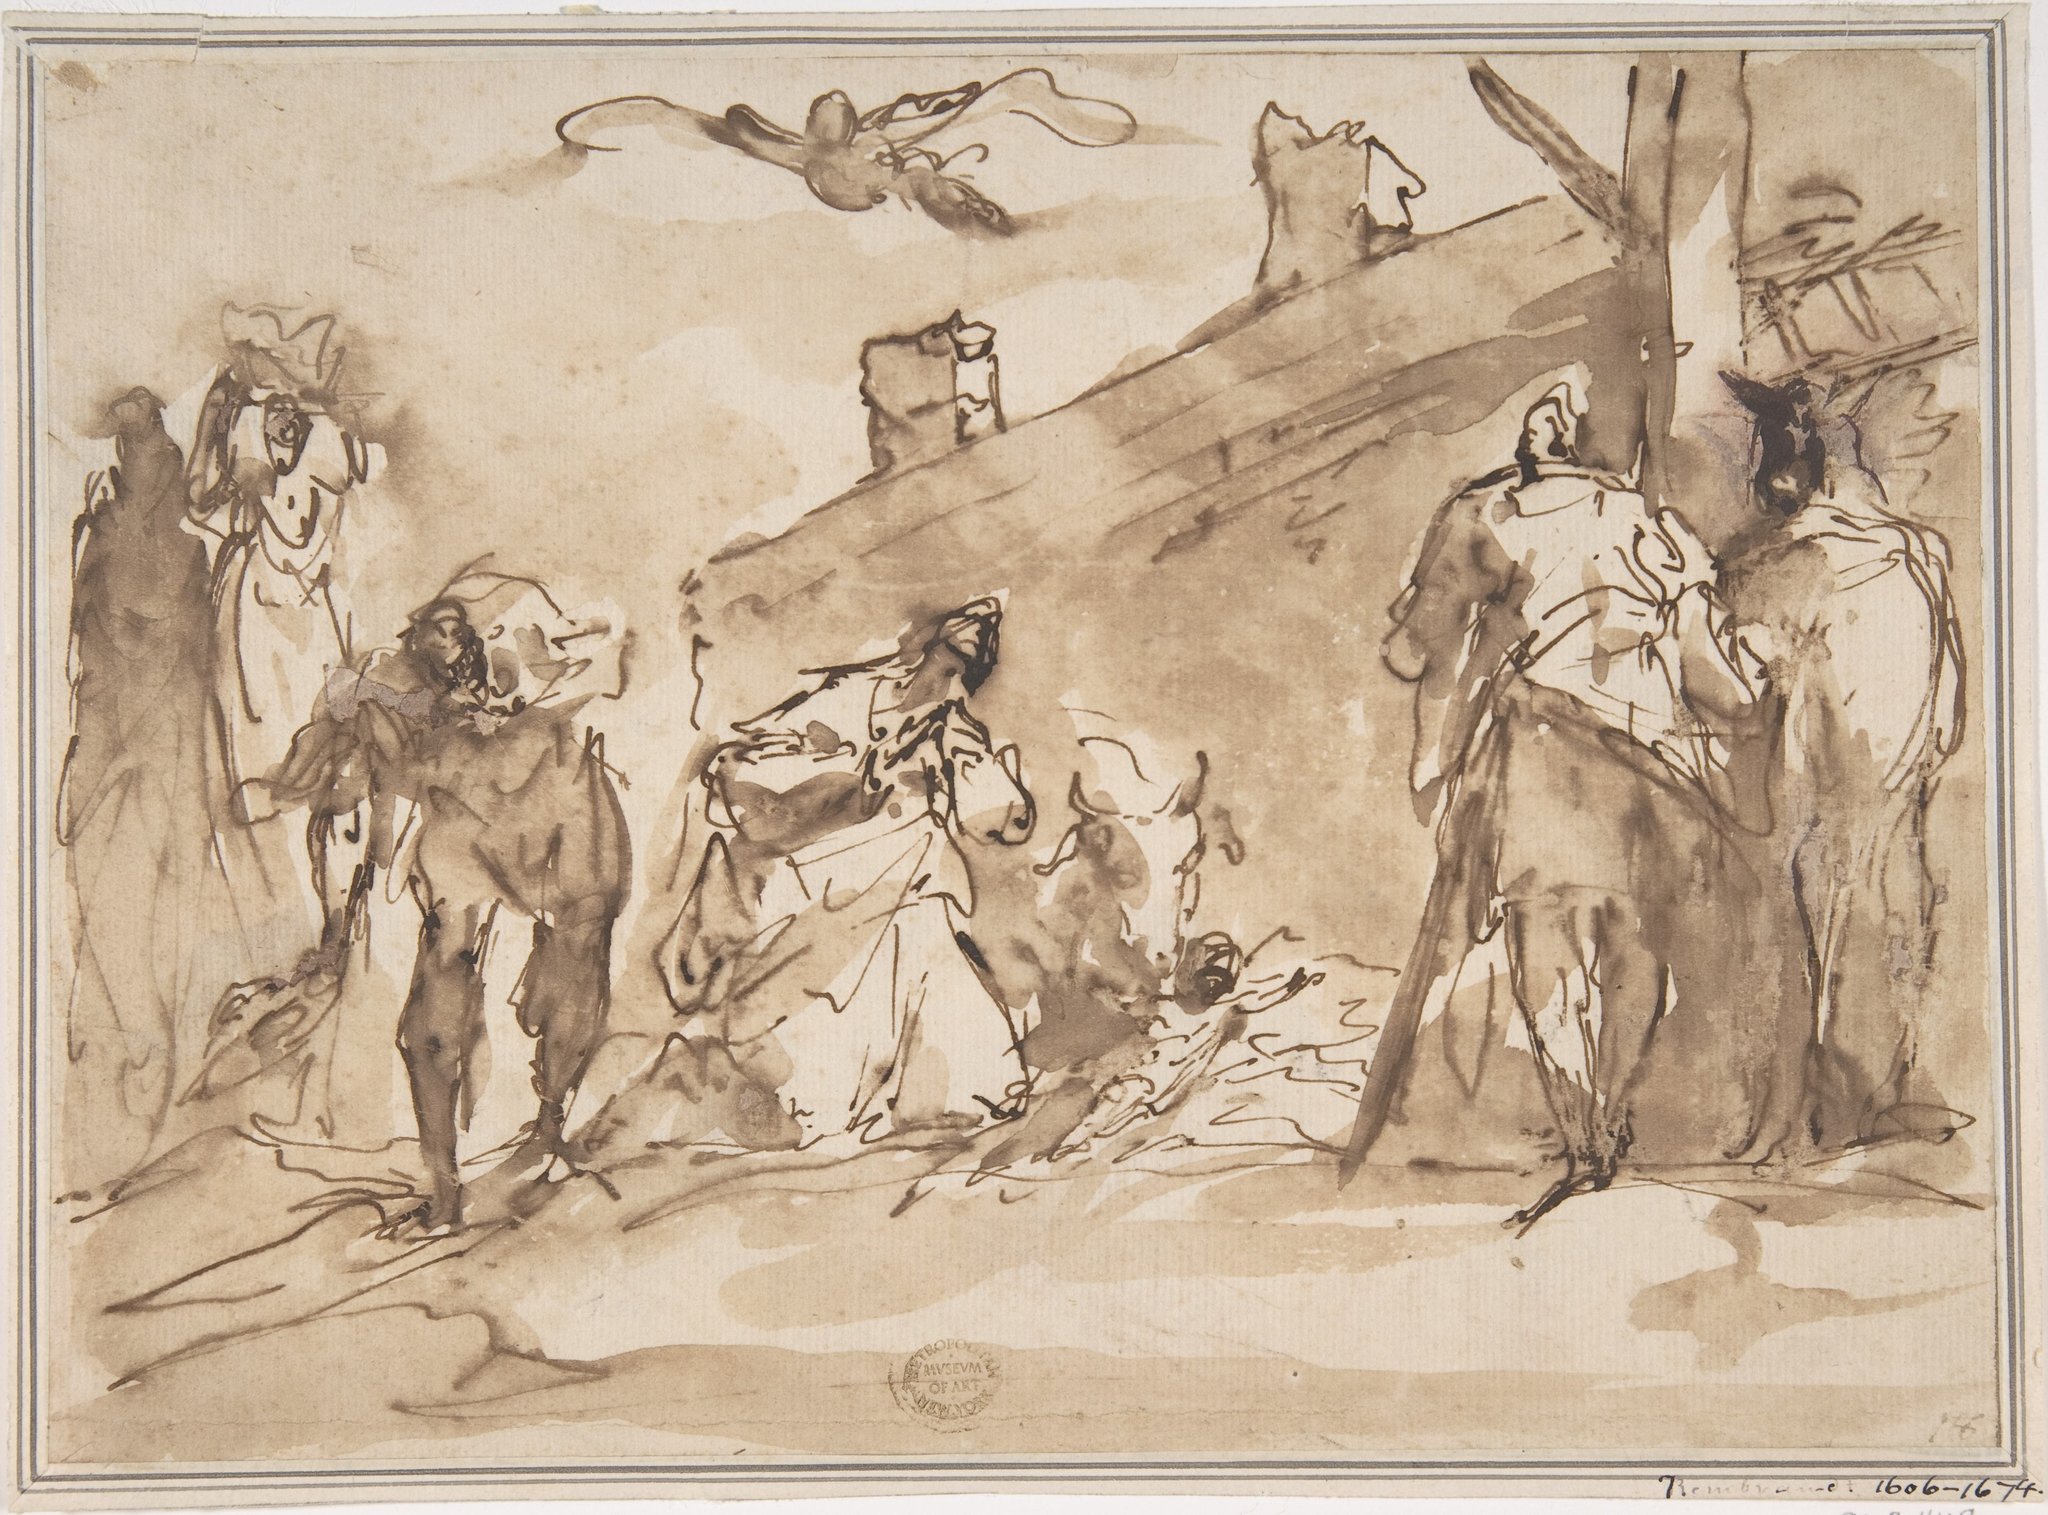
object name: drawing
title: Sketch for Adoration of the Kings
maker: anonymous, french, 17th century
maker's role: artist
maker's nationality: french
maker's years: 1600-1700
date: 1601-1633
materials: ink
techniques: brush, pen, wash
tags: animals,men,jesus